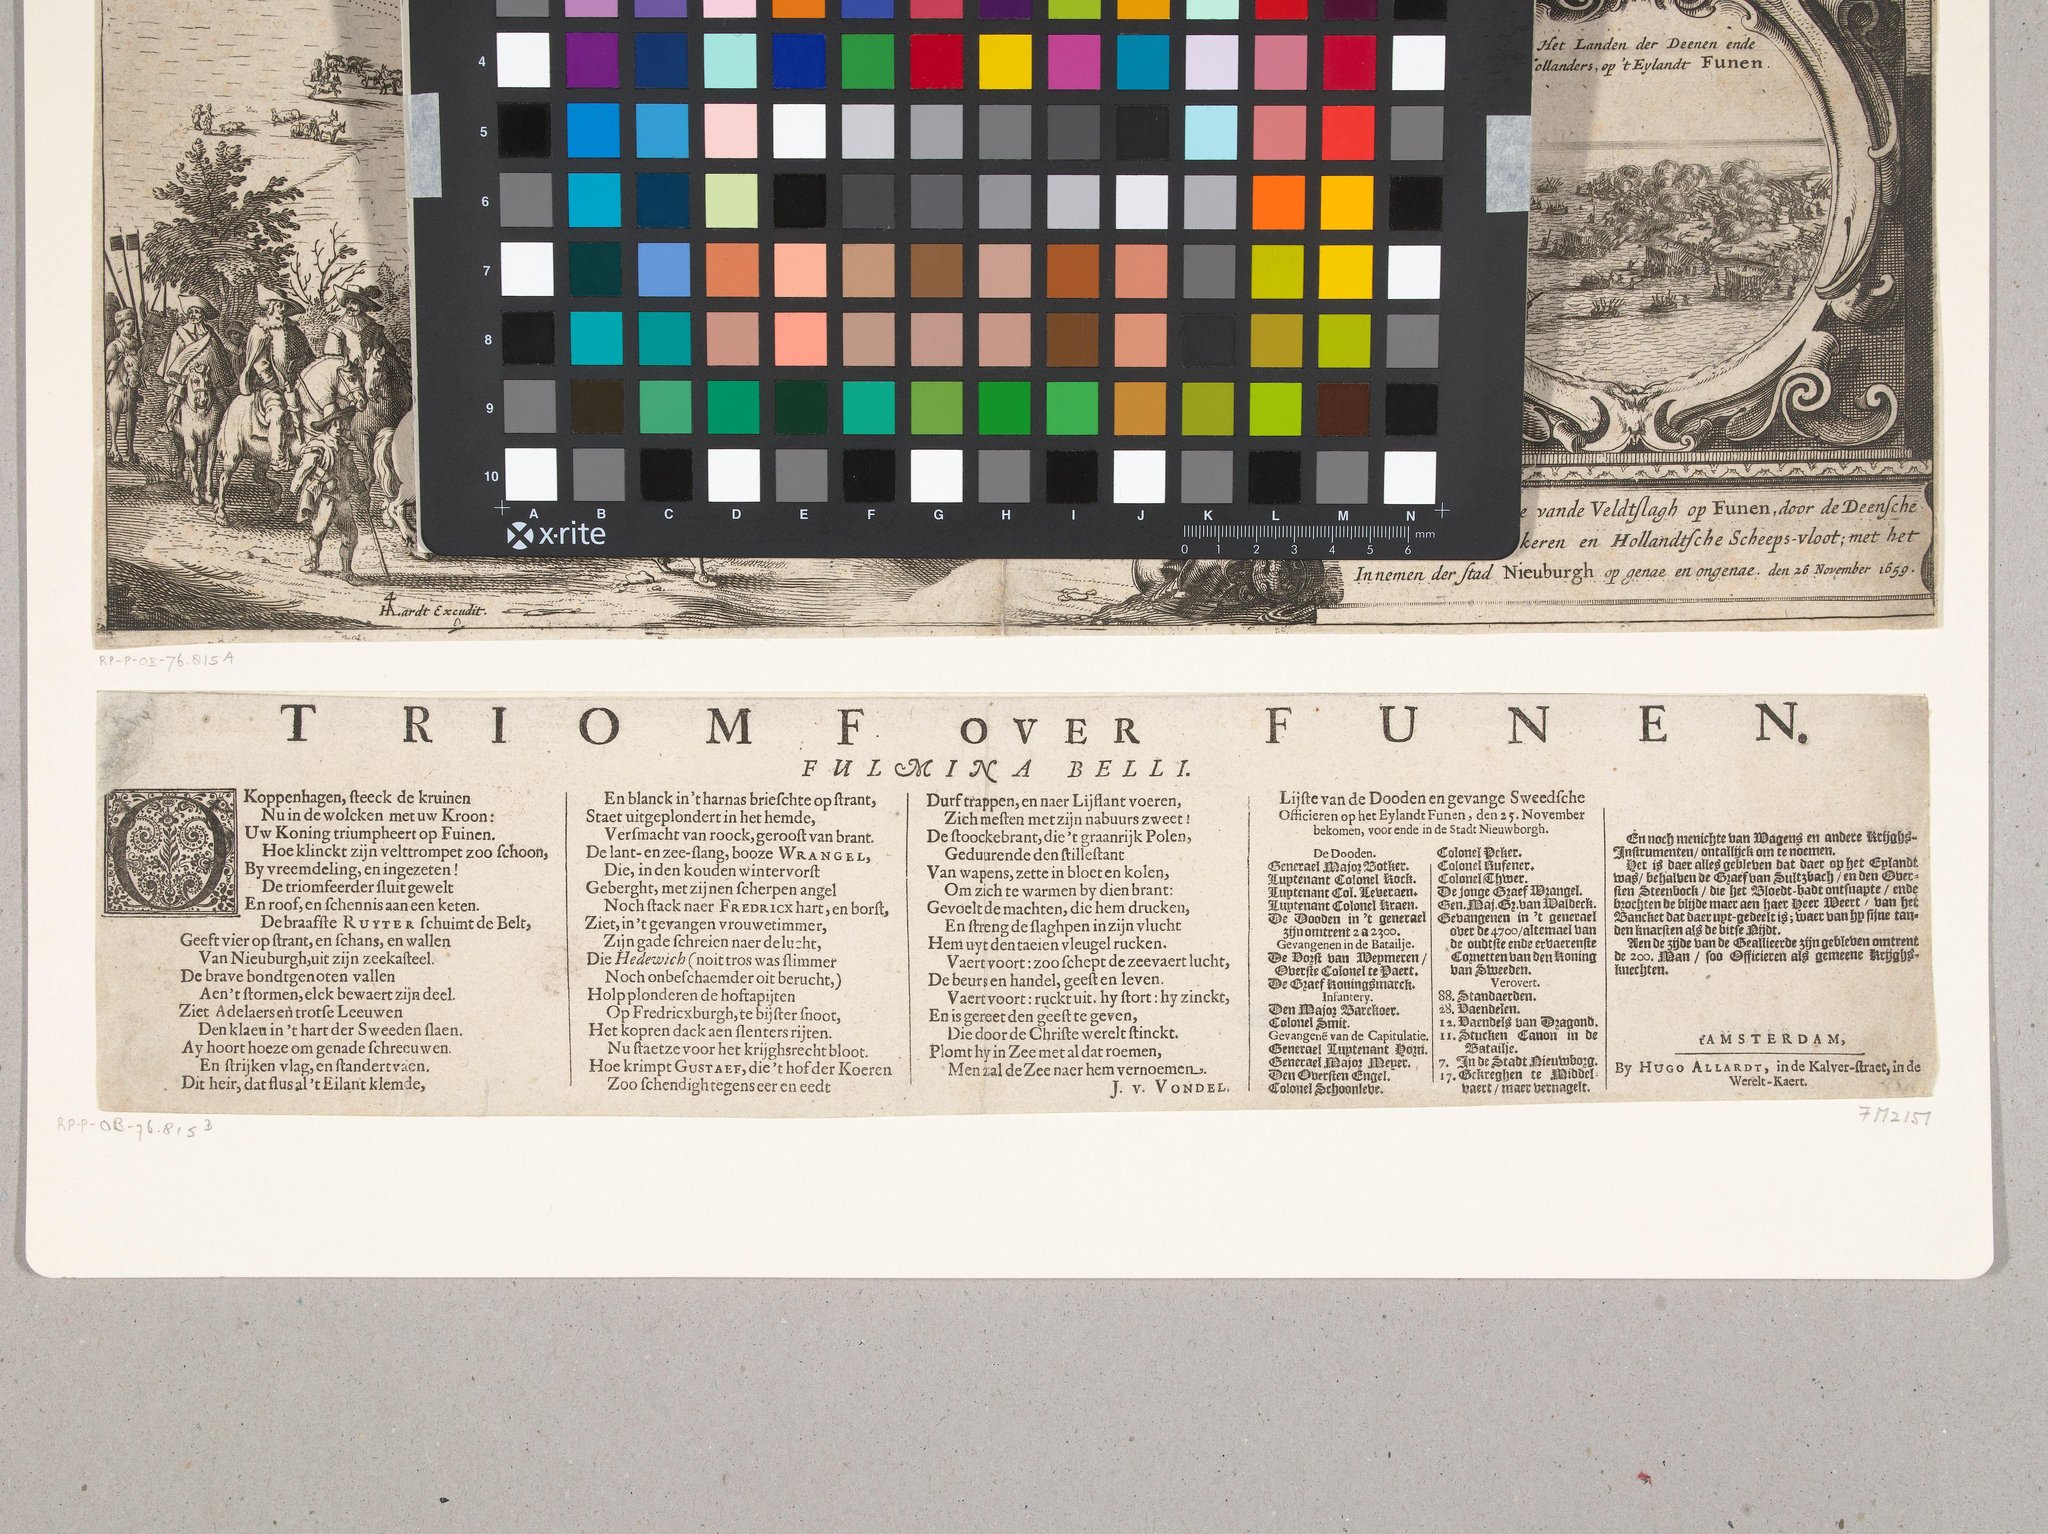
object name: text sheet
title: Tekstblad bij de prent van de nederlaag der Zweden op Funen, 26 november 1659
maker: hugo allard (i)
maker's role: draughtsman, painter, print maker, publisher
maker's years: 1620-1684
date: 1659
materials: paper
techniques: letterpress printing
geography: amsterdam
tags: flushing, michiel adriaenszoon de ruyter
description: Tekstblad bij de prent van de inname van de stad Nyborg door Michiel Adriaenszoon de Ruyter en het verslaan van het Zweedse leger door de Denen, 25-26 november 1659. Gedicht in 3 kolommen gevolgd door een lijst van gesneuvelde en gevangengenomen Zweedse officieren.